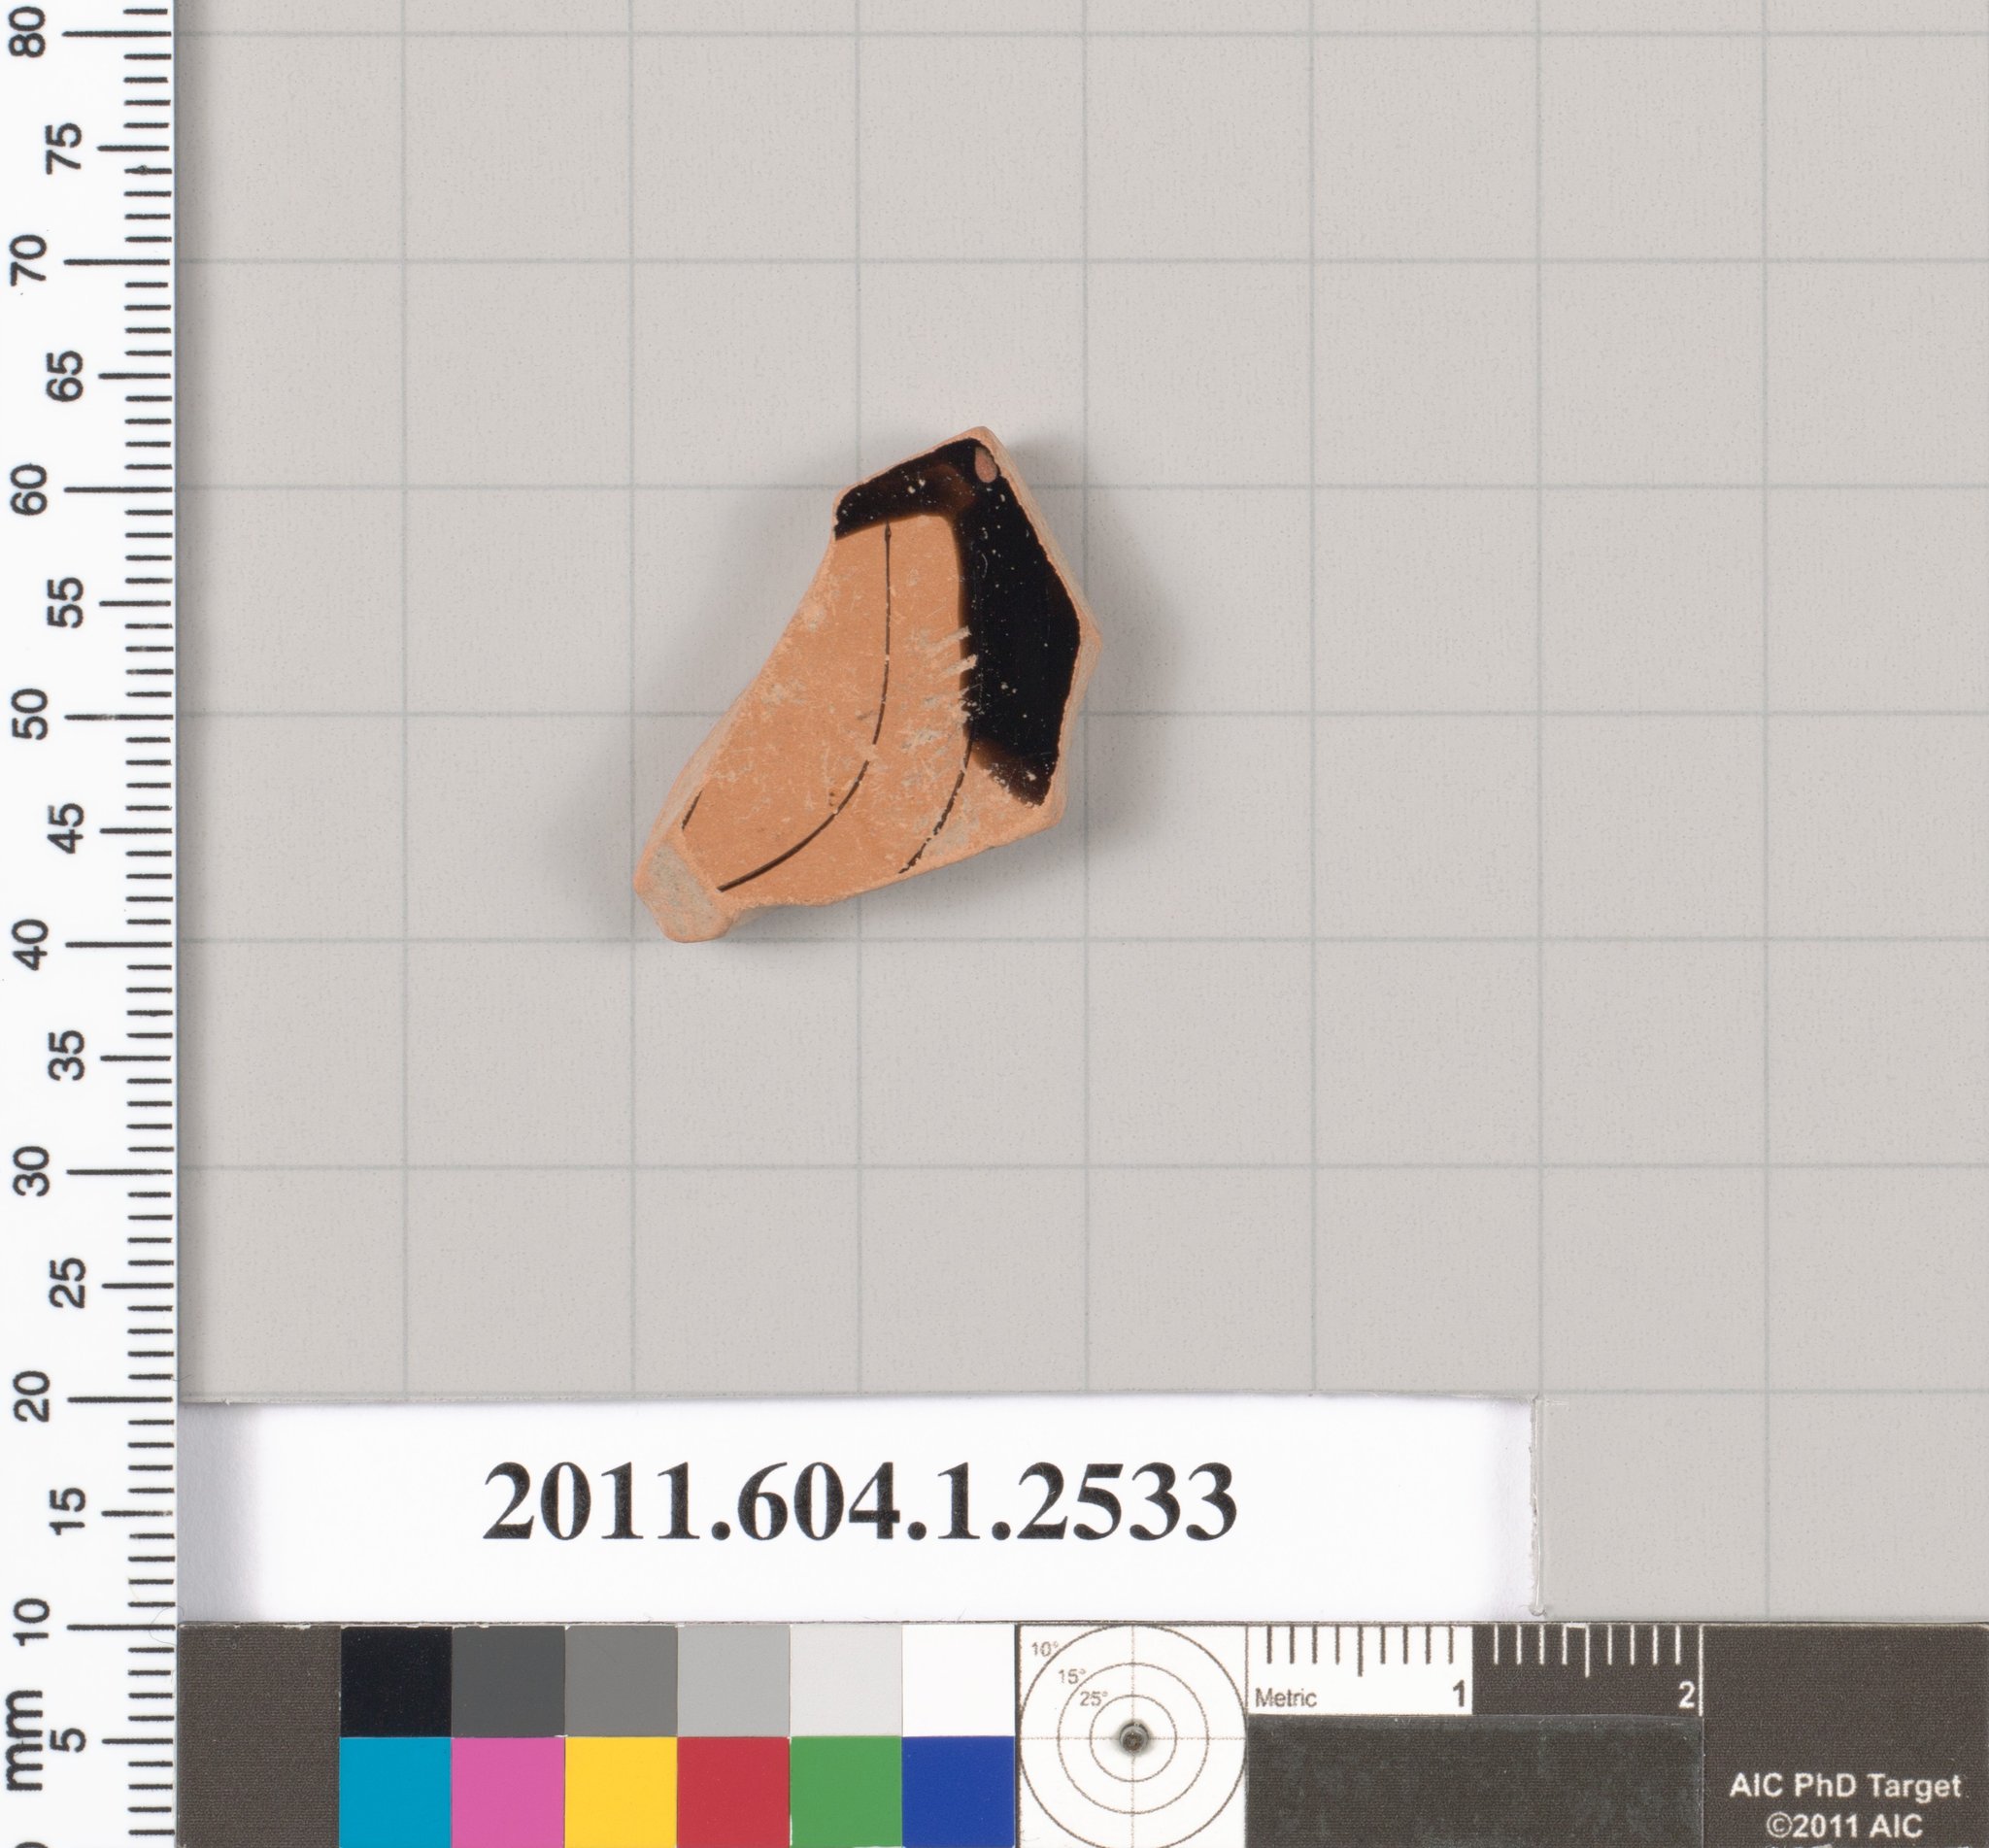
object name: kylix fragment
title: Terracotta fragment of a kylix (drinking cup)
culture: greek, attic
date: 475-451 BCE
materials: terracotta